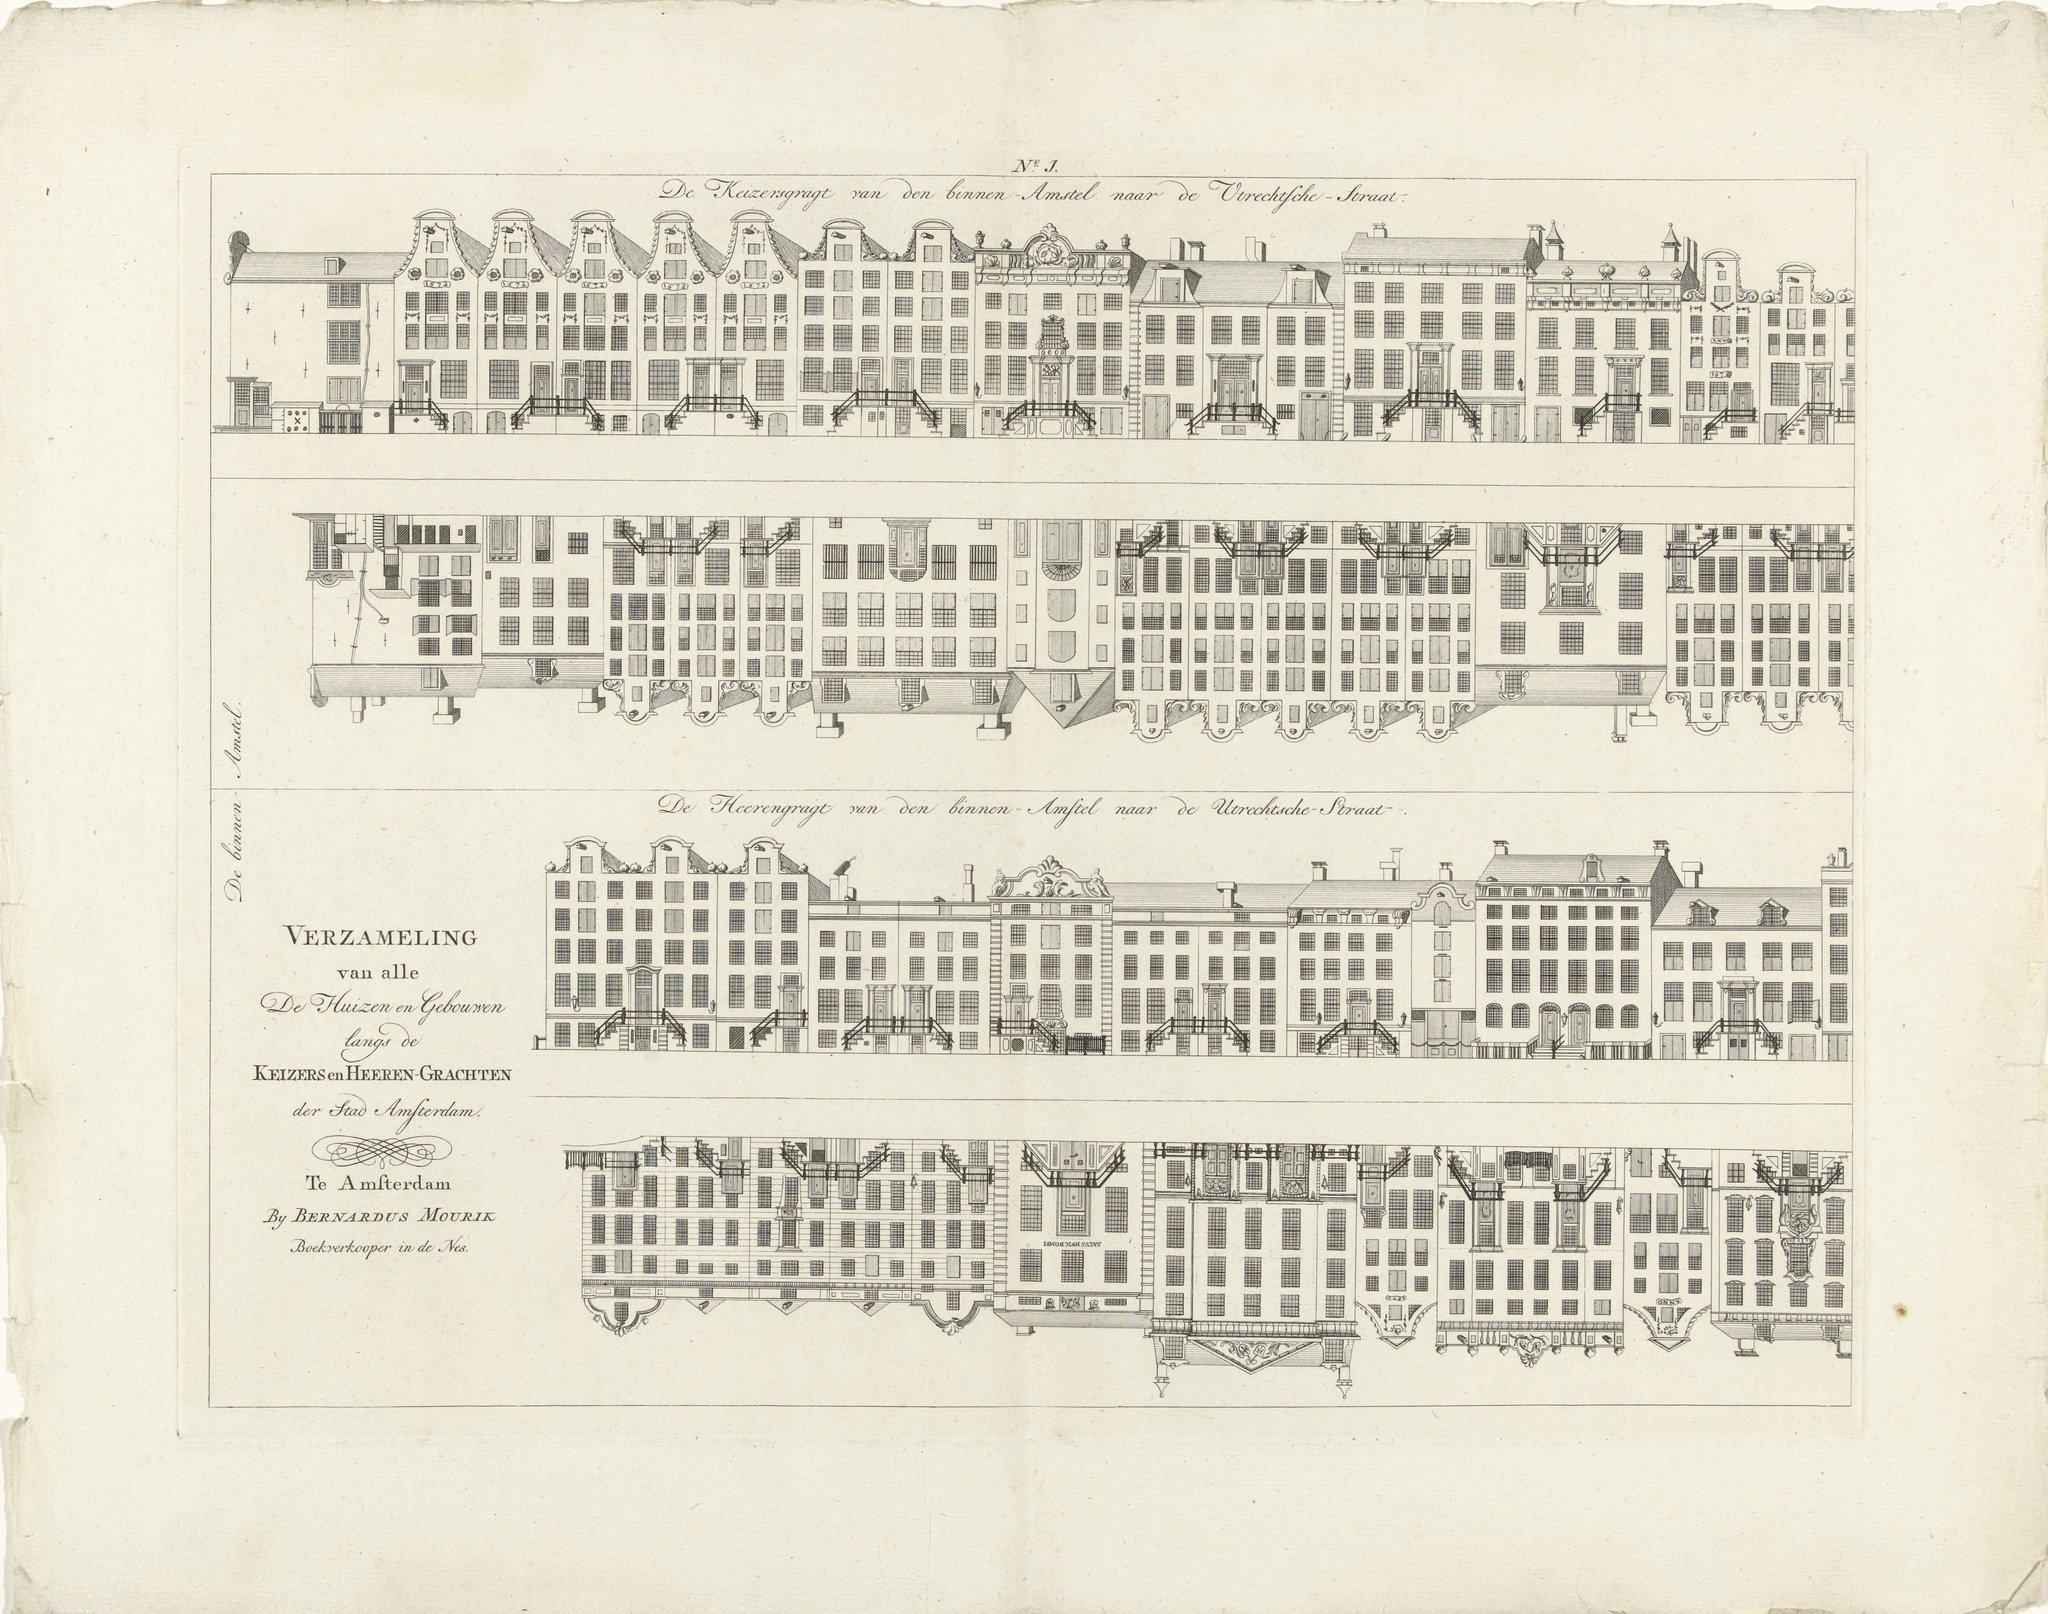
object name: print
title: Gevels van huizenrijen aan de Keizersgracht van de Binnen-Amstel naar de Utrechtsestraat en de Herengracht van de Binnen-Amstel naar de Utrechtsestraat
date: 1768-1771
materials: paper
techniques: etching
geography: amsterdam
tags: front façade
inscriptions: collector's mark: Lugt 2228, collector's mark: Lugt 2233